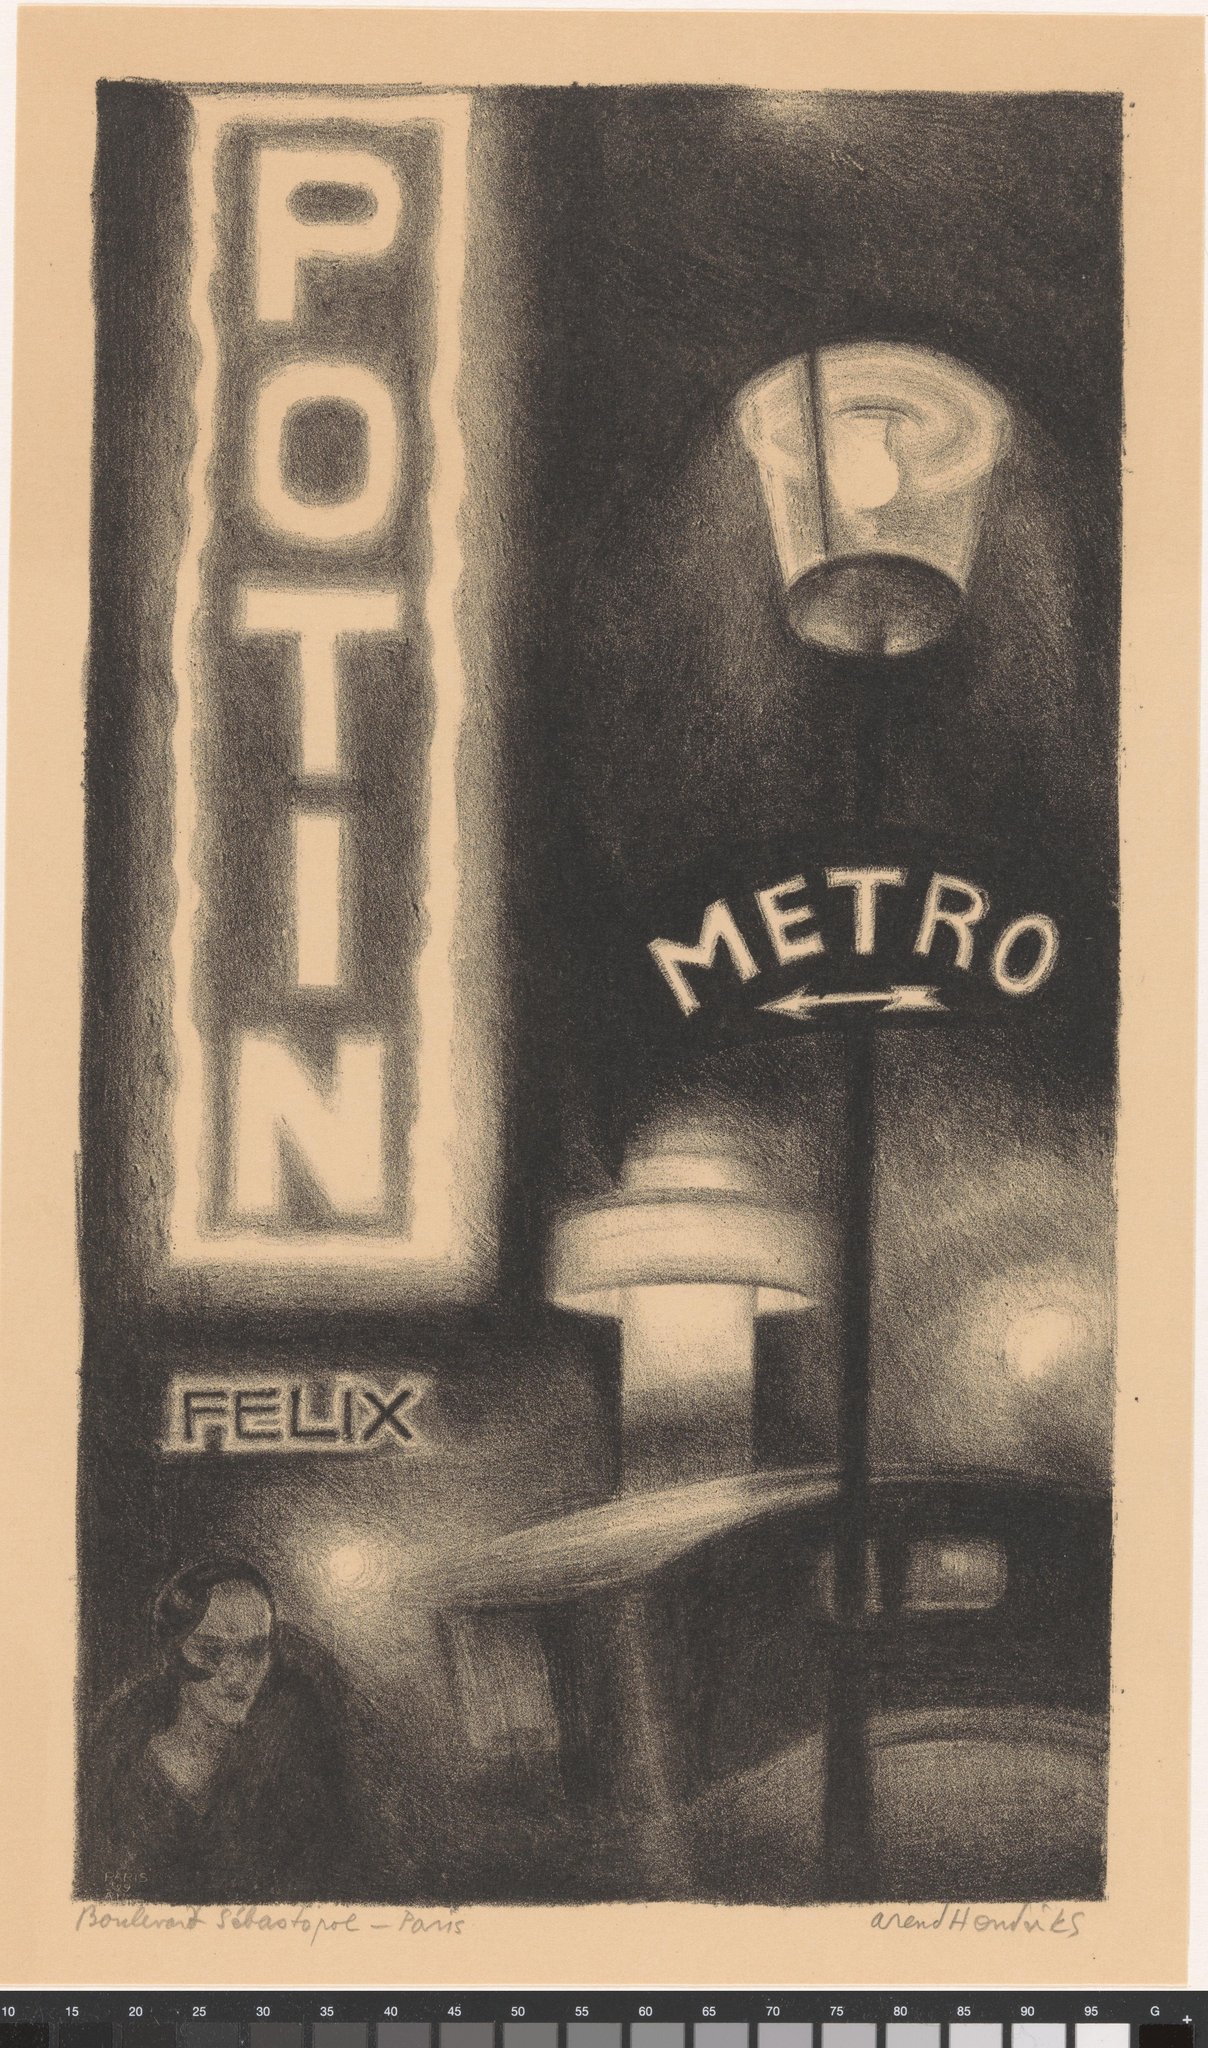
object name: print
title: Boulevard de Sébastopol, Paris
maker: arend hendriks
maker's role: print maker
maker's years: 1901-1951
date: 1929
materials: paper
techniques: lithograph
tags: underground railway, 'métro', neon lamp, neon tube, street lighting, automobile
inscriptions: collector's mark: Lugt 2228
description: Arend Hendriks never tired of electric street and advertizing lighting in Paris, as evidenced by the many lithographs he made of the subject. In this one, a woman walks past a car parked near a lamppost with a sign pointing the way to the metro. Behind her are illuminated signs for a branch of the Félix Potin grocery shop.